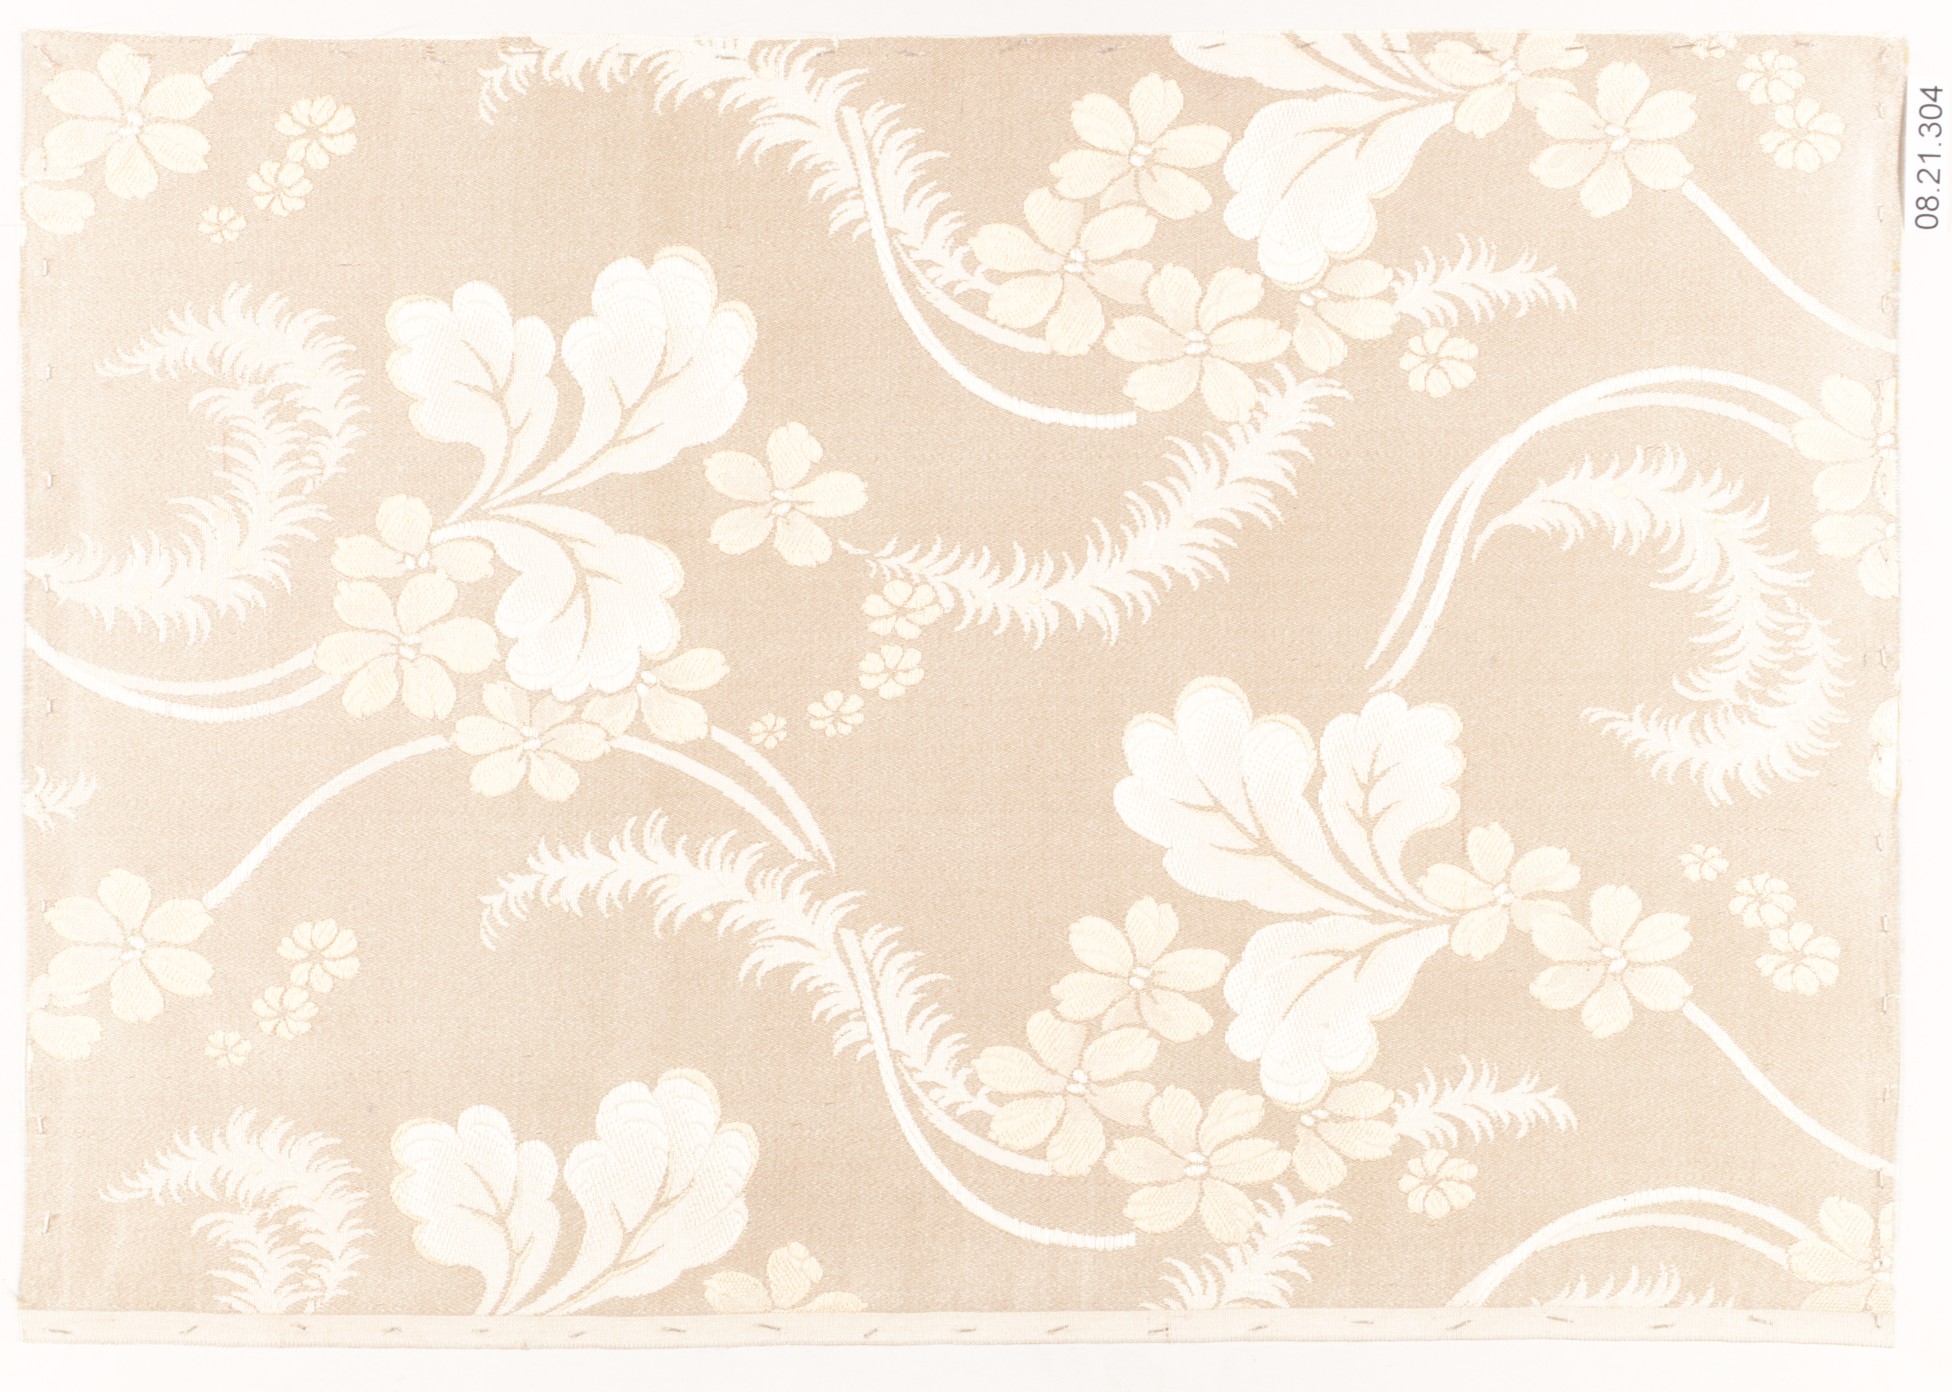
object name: textile sample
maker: Anonymous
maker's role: designer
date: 1900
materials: silk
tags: flowers,leaves